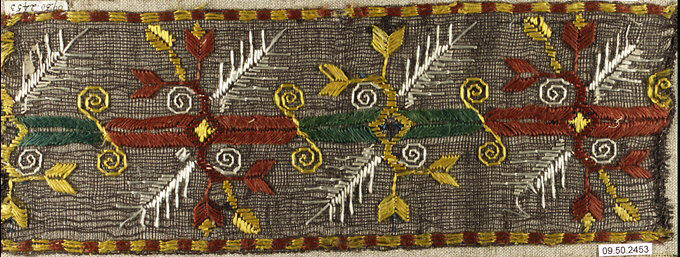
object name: strip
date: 1601-1700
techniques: embroidery